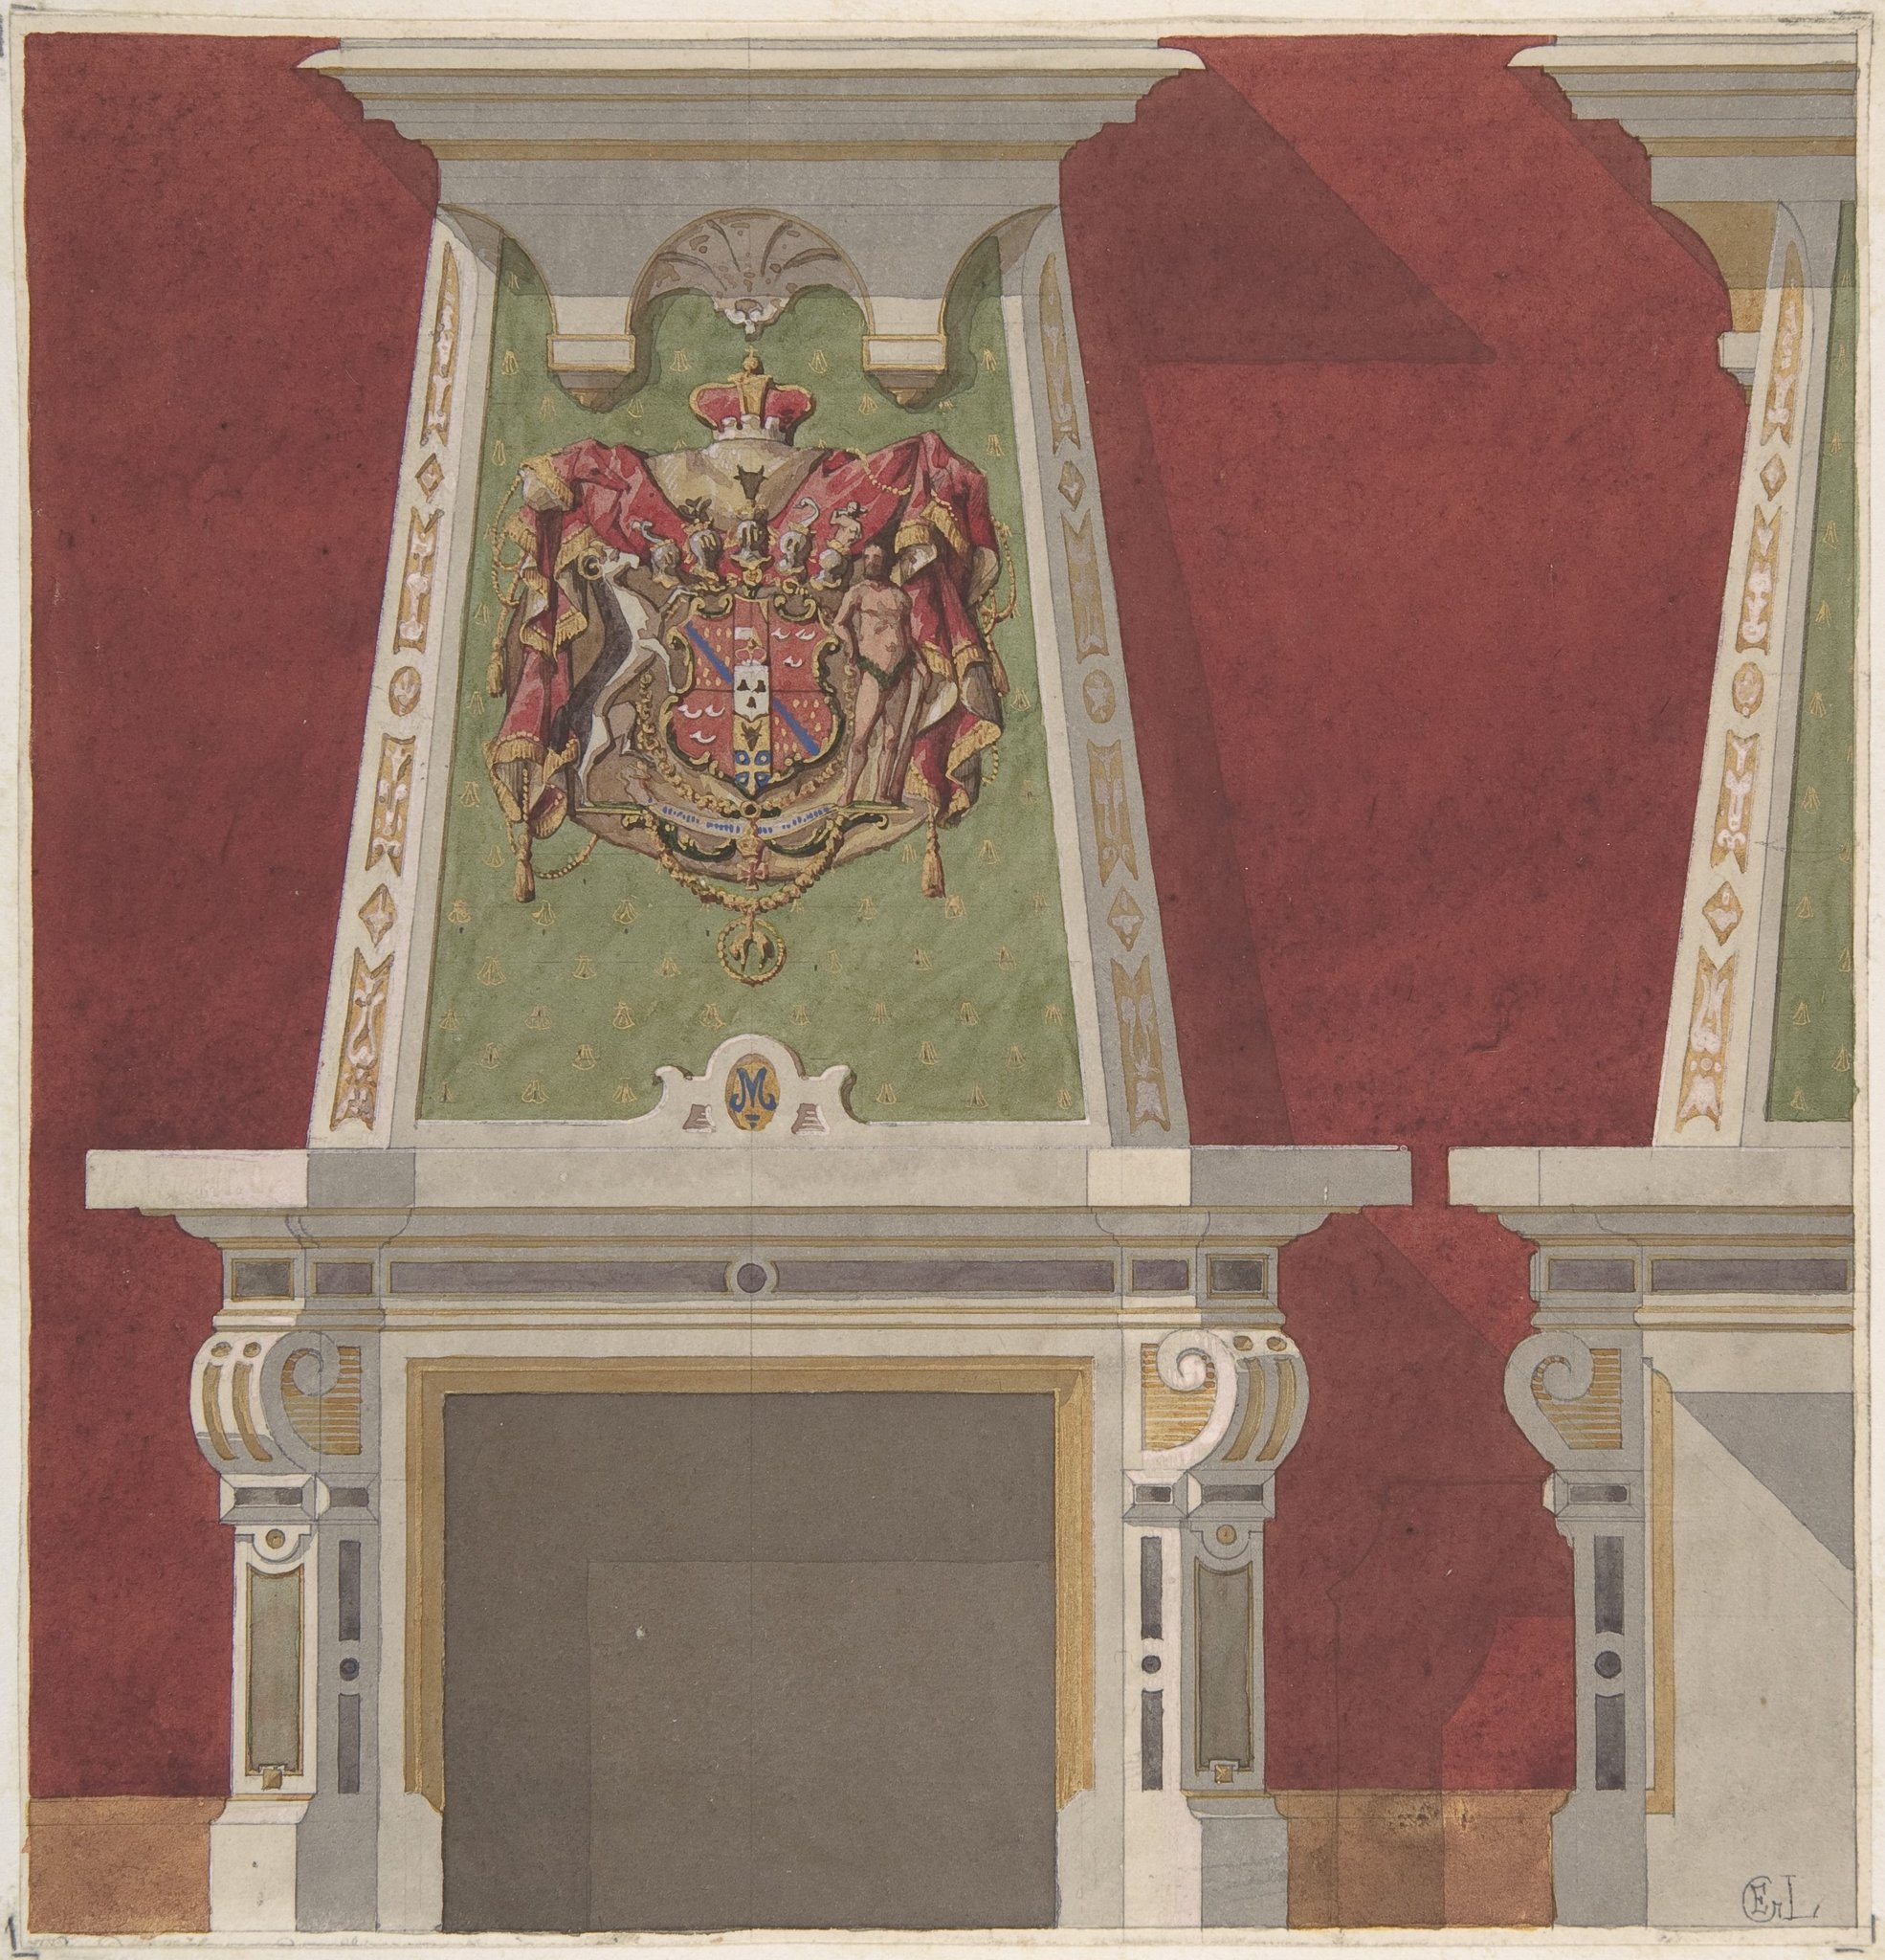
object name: drawing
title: Design for Chimney Piece, Château du Duc de Meternick, Johannisburg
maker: jules-edmond-charles lachaise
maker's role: artist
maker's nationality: french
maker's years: 1897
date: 1851-1900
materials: gilt, ink, watercolor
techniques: pen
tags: animals,men,coat of arms